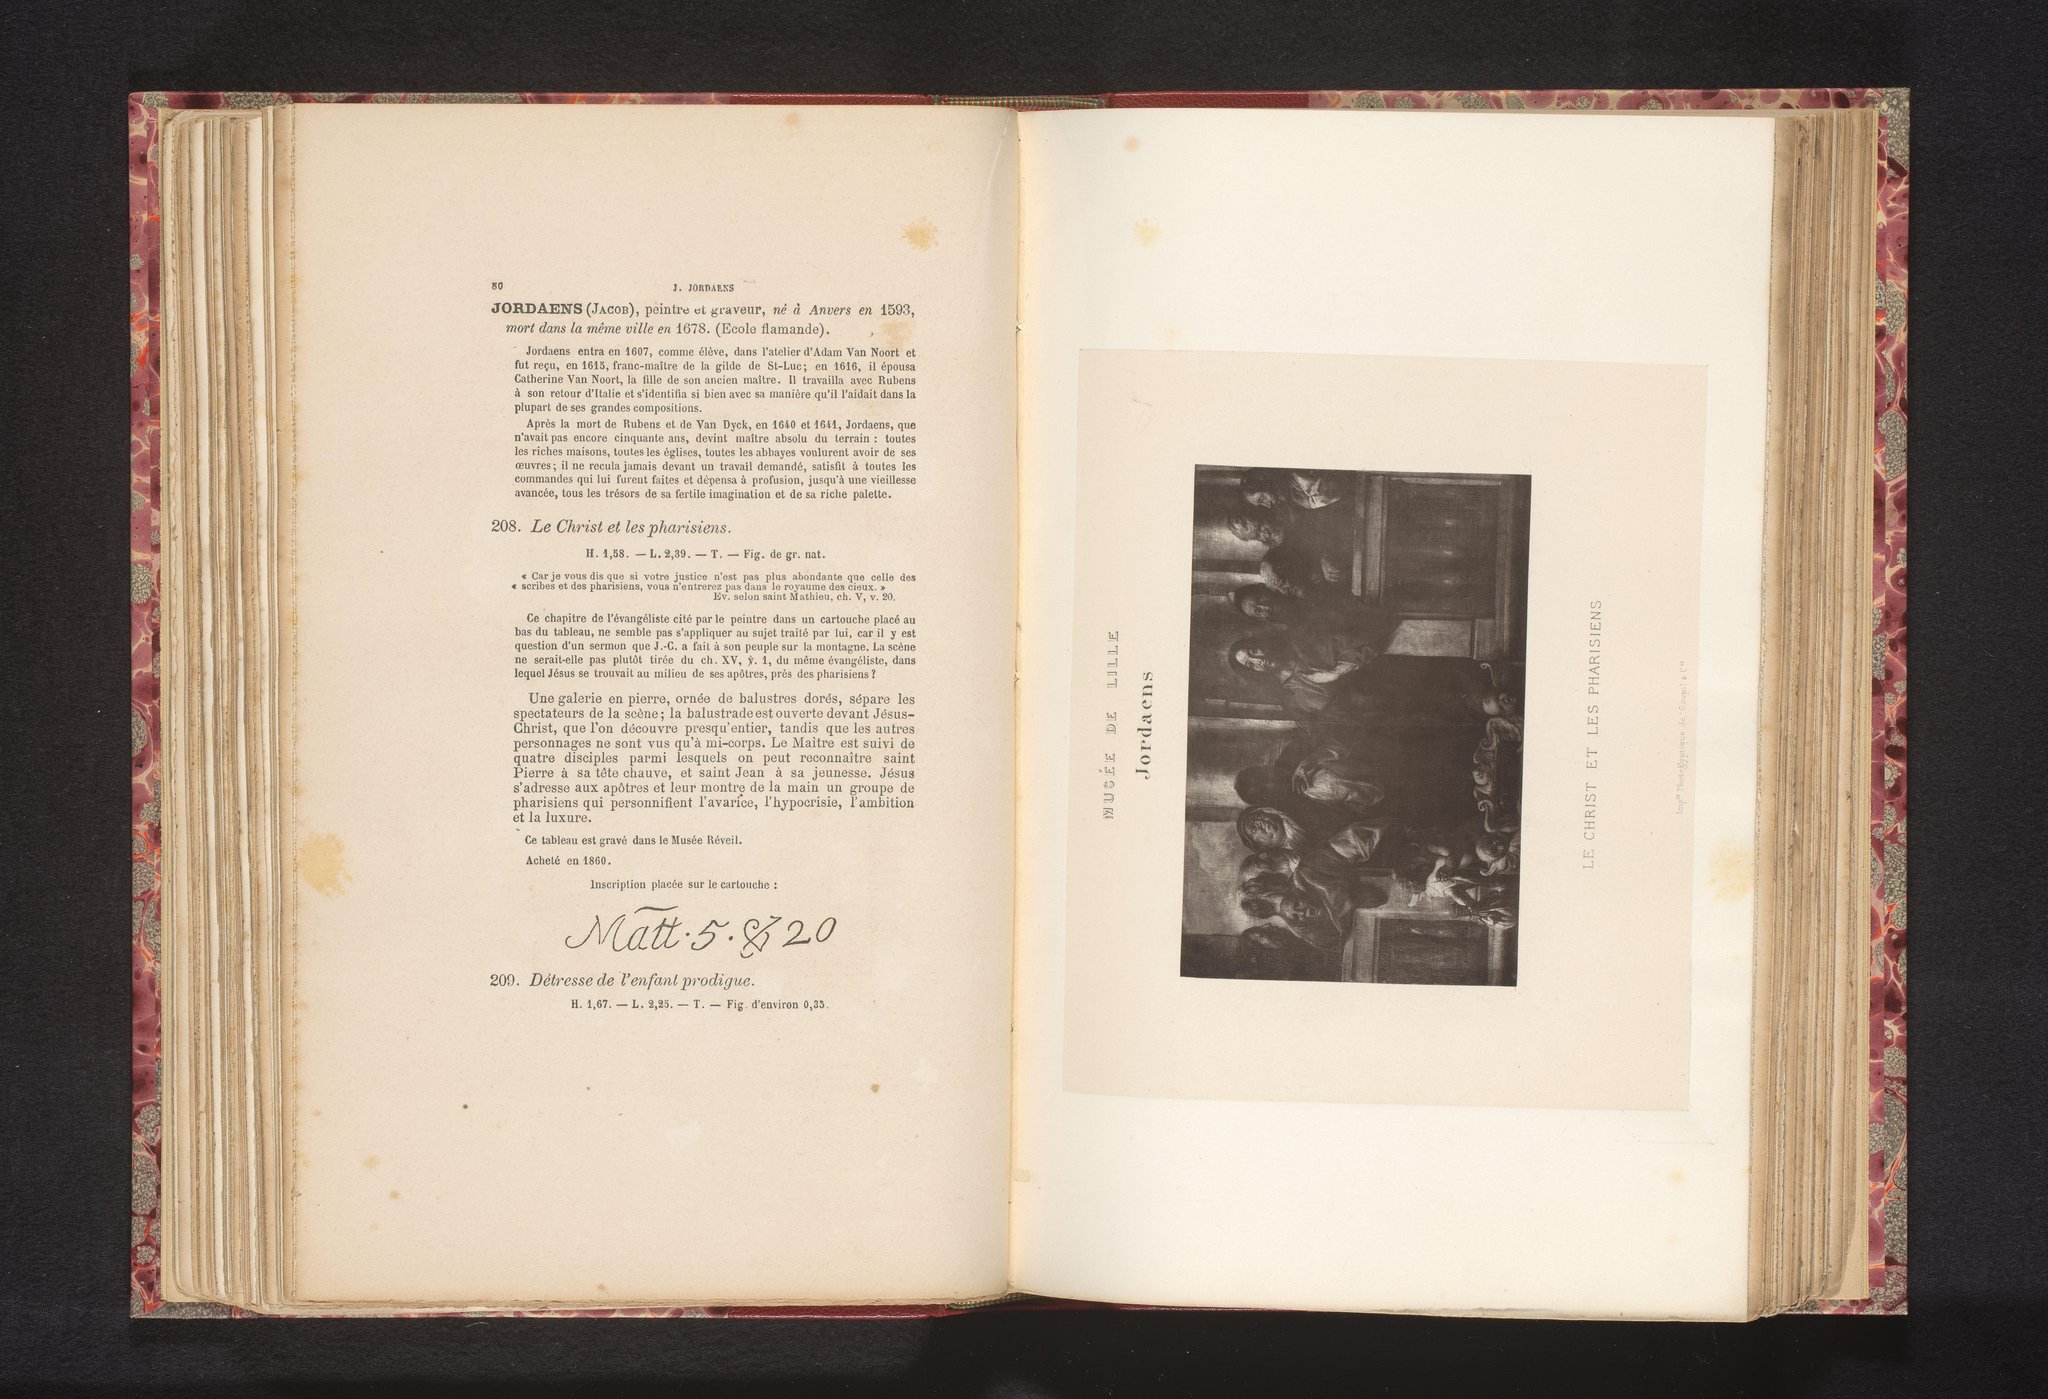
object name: page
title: Le Christ et les Pharisiens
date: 1862-1872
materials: paper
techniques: woodburytype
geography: lille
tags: speeches of christ against scribes and pharisees (matthew 23; mark 12:38-40; luke 11:42-52, 20:45-47)